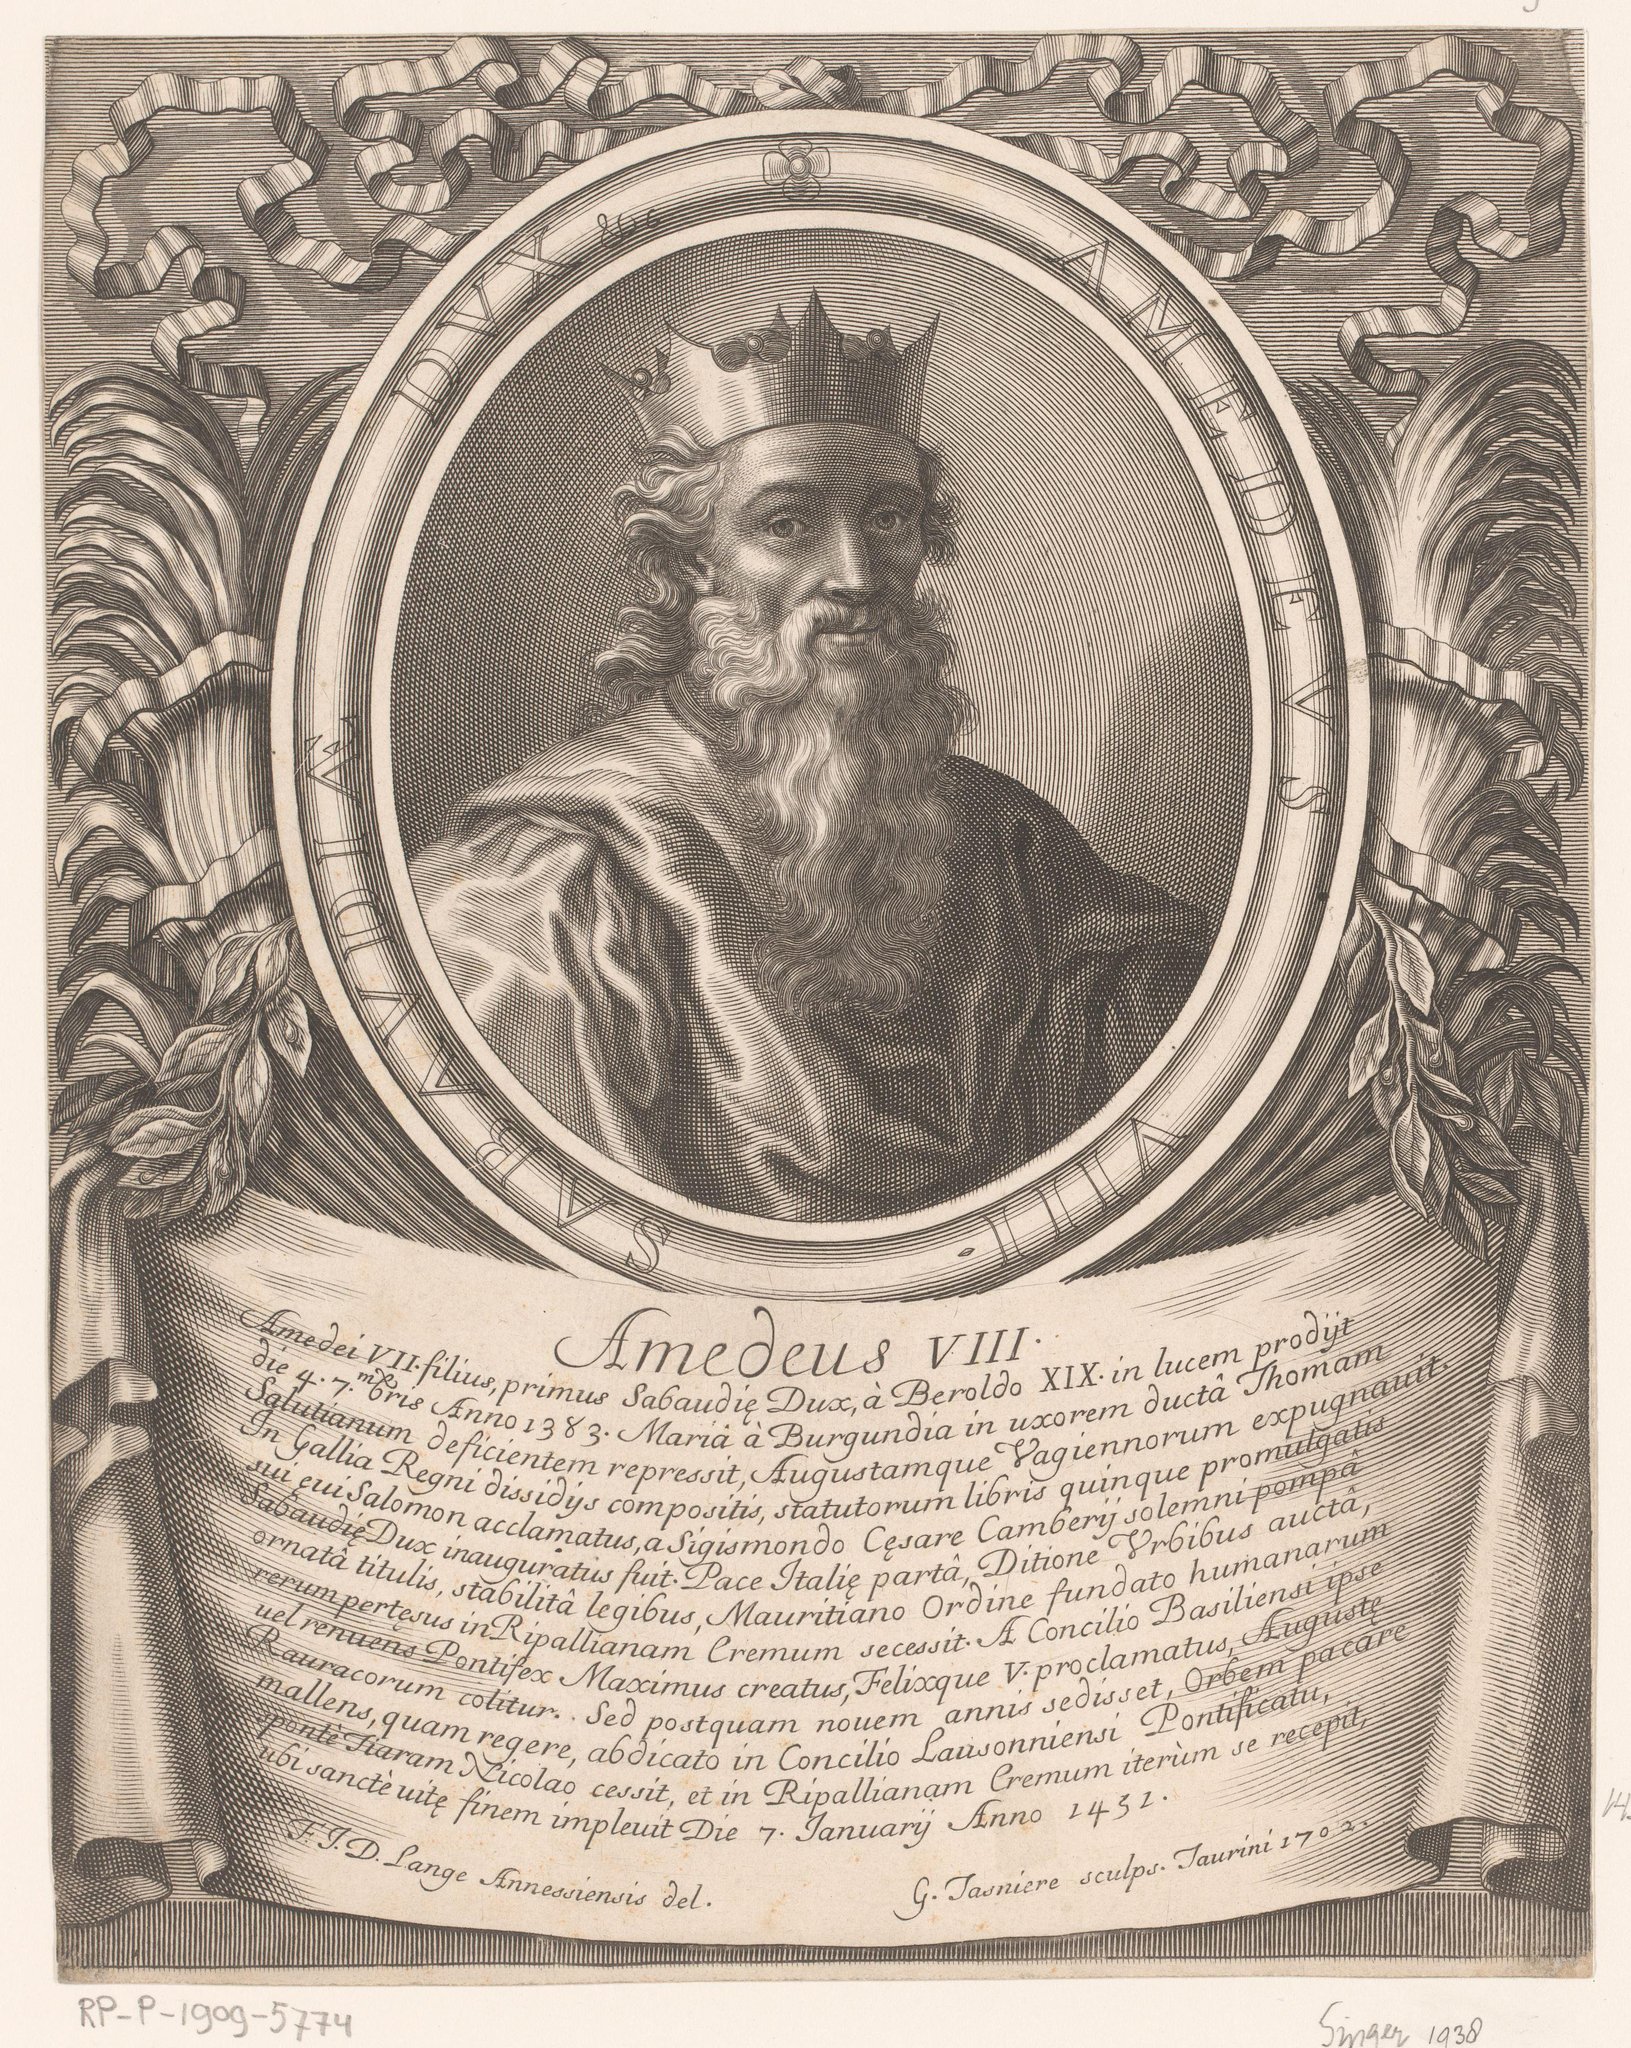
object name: print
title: Portret van hertog Amadeus VIII (tegenpaus Felix V)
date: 1702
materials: paper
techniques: engraving, etching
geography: annecy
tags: historical persons (portraits and scenes from the life) (+ half-length portrait)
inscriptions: collector's mark: Lugt 2228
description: Maakt deel uit van een serie getiteld 'Augustae regiaeque Sabaudae domus Arbor gentilitia regiae celsitudini Victori Amedeo II' met portretten door Giffart en Tasnière van leden van het Huis van Savoye, uitgegeven in 1702 door Francesco Maria Ferrero di Lavriano.